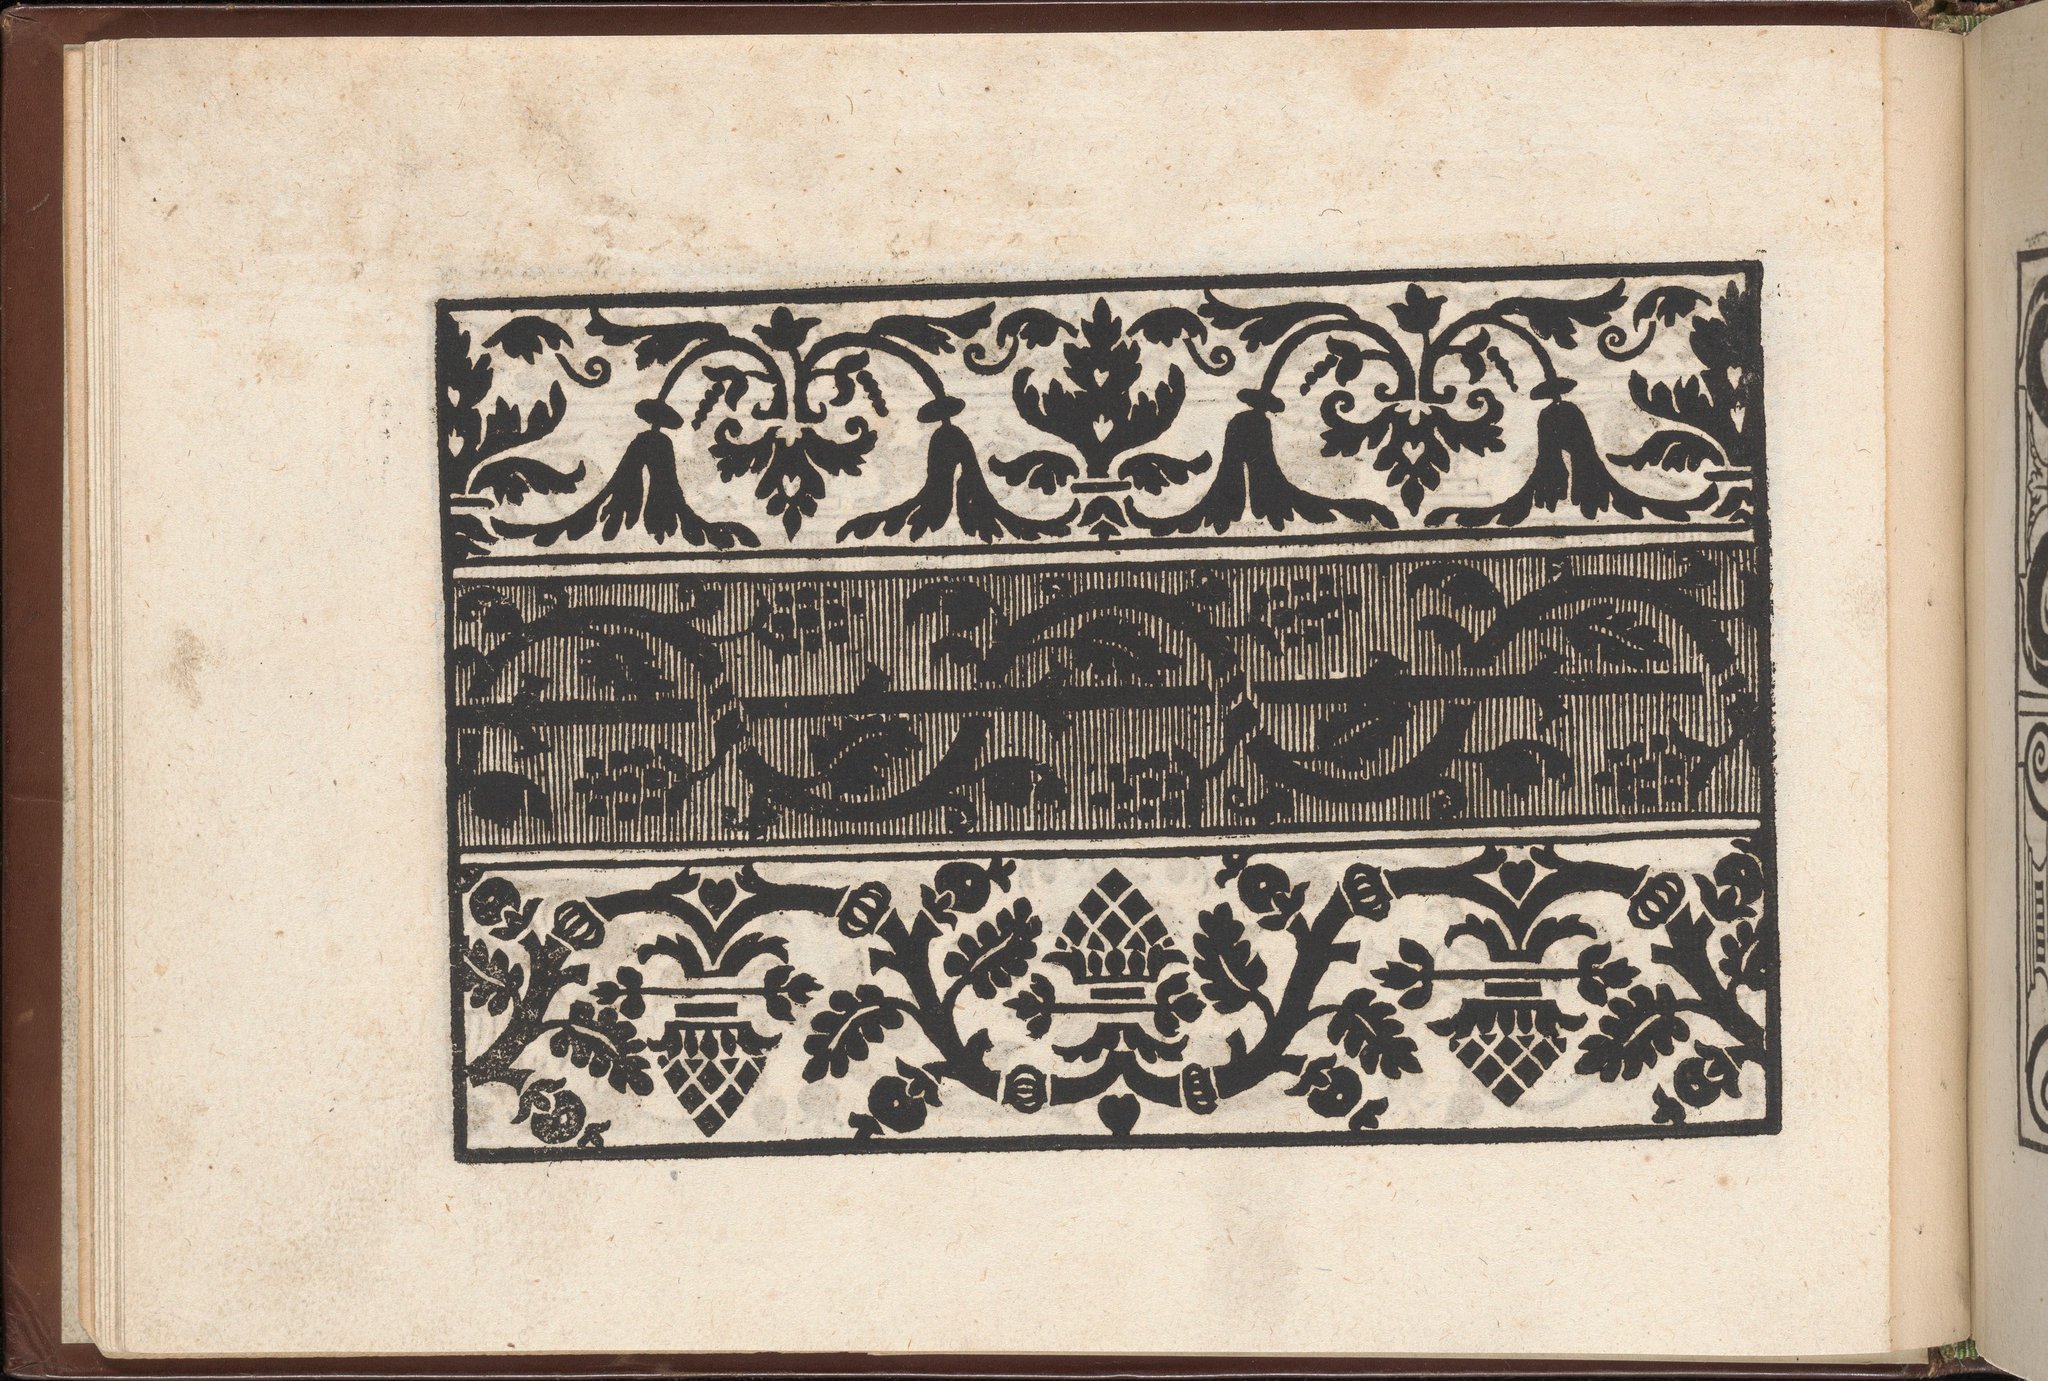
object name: book print ornament architecture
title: Page from Eyn Newe kunstlich moetdelboech alle kunst (Page 8v)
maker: peter quentel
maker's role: publisher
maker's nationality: german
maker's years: 1500-1550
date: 1532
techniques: woodcut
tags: flowers